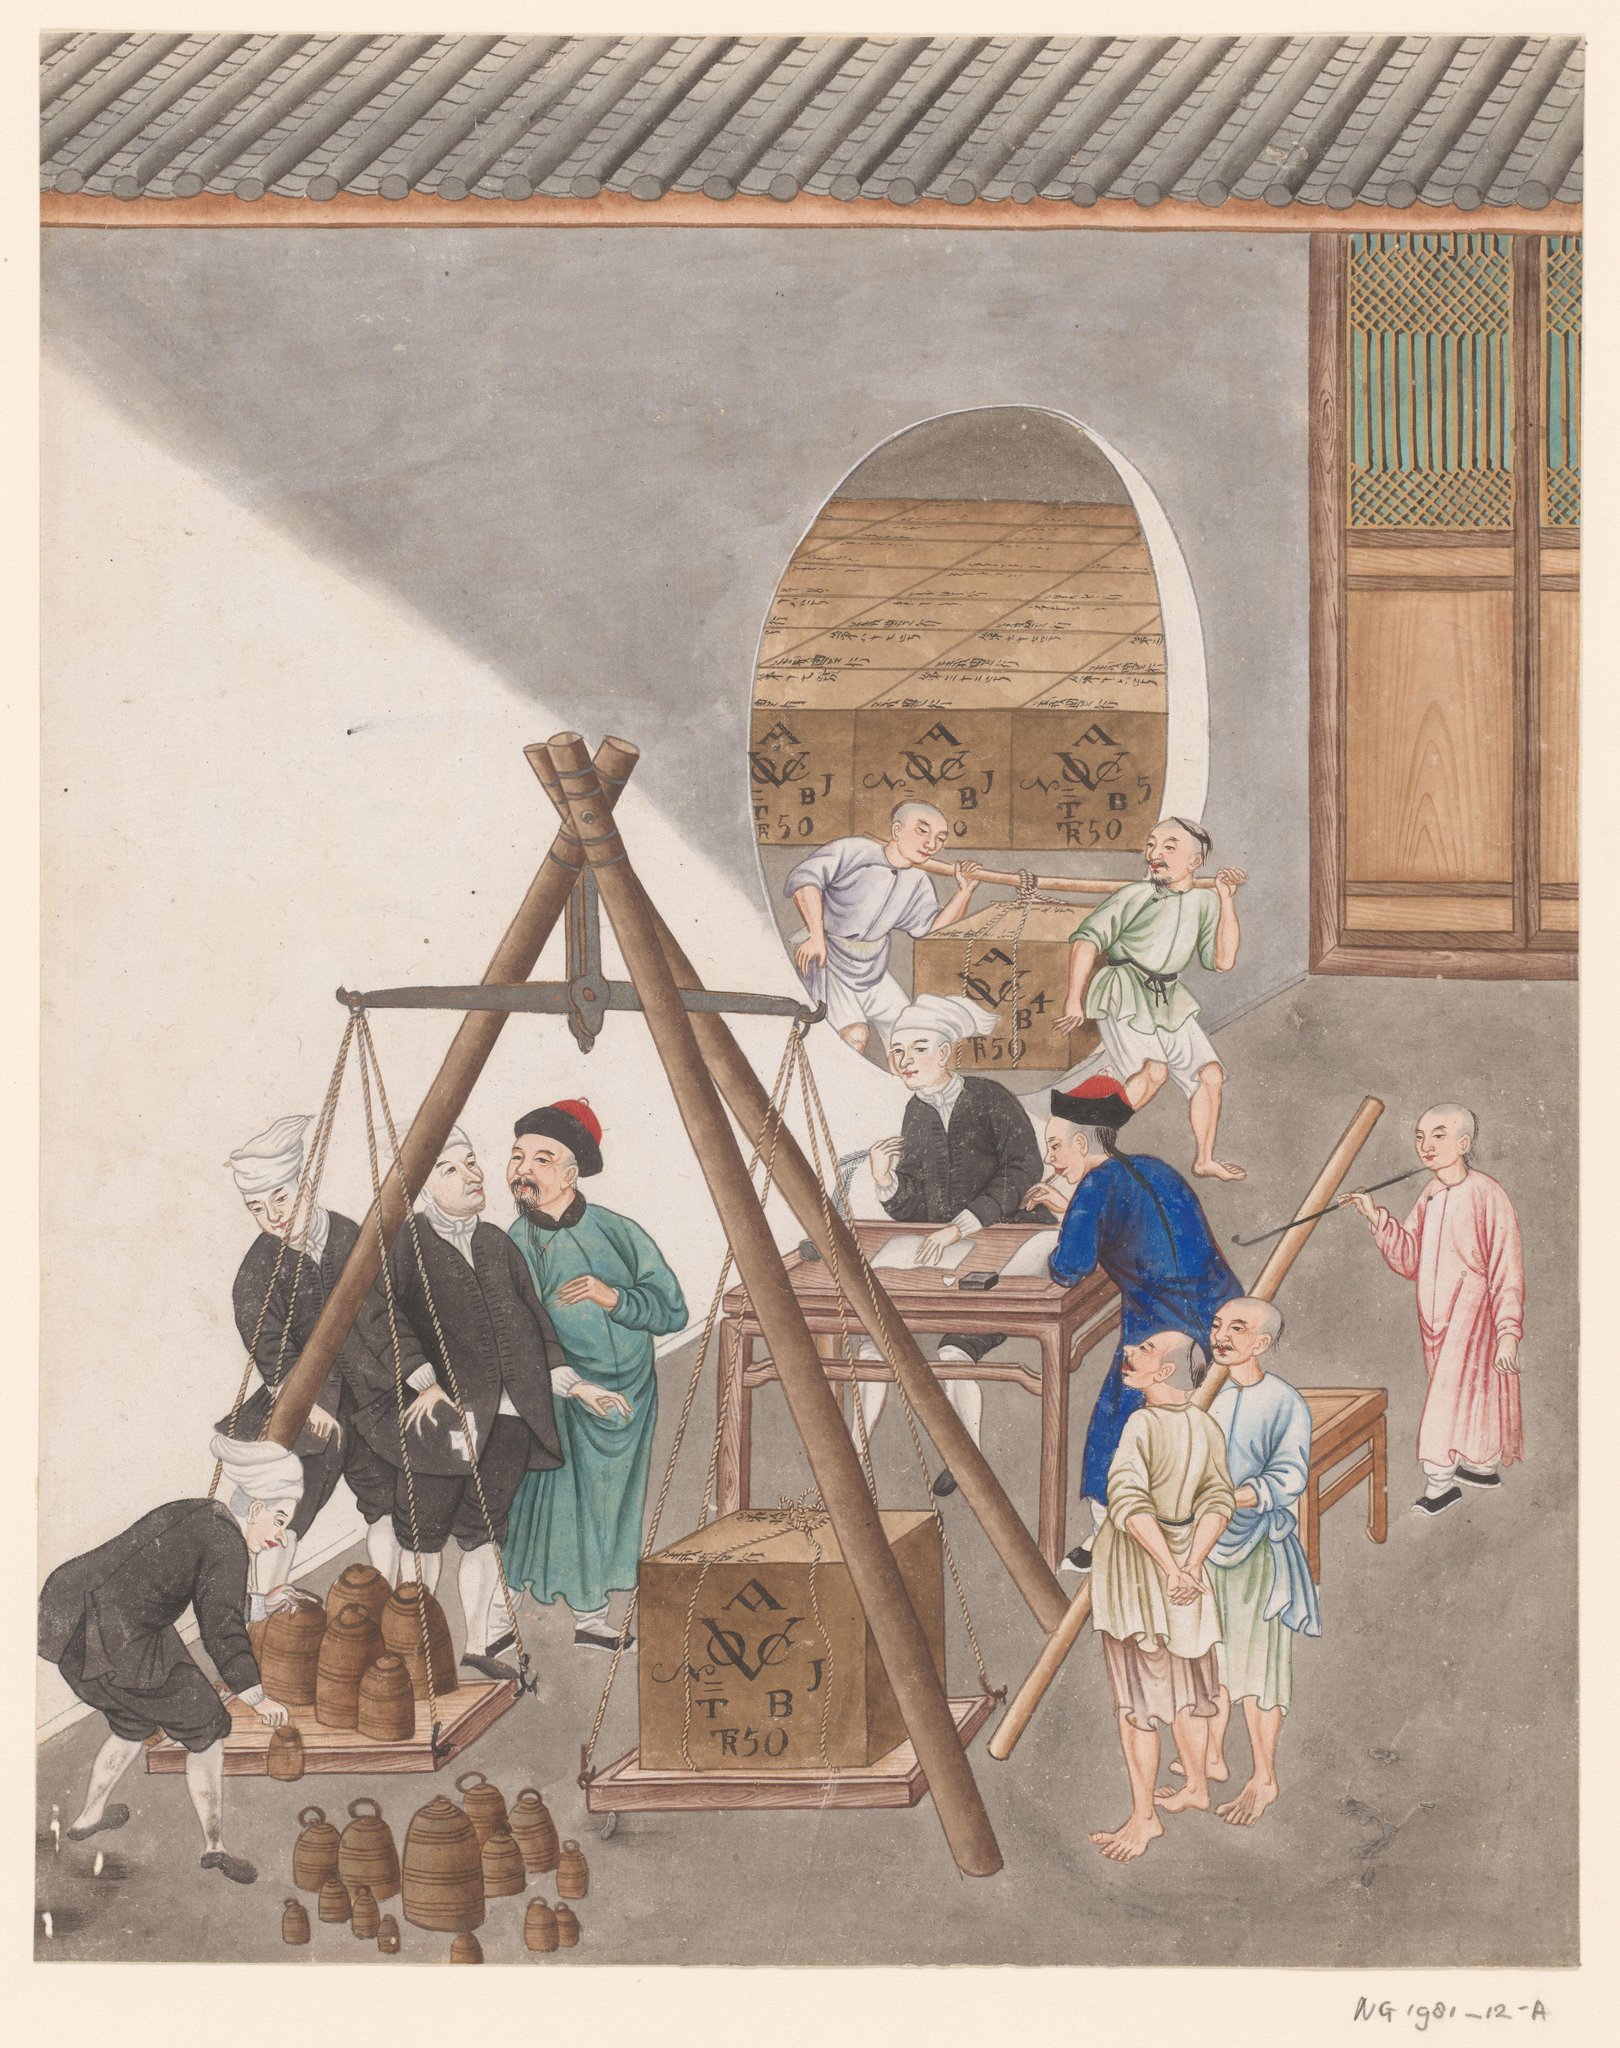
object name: drawing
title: Determining the weight of the tea chests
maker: Anonymous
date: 1770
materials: paint, gouache, paper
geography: china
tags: large-scale structure for storage, e.g.: warehouse, depot, silo, scales, tea (leaves), china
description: Het wegen van een kist met thee waarop het VOC insigne in een Chinees handelshuis in Kanton. Doorkijk in een ruimte vol met kisten met het VOC insigne en de naam van het Chinese handelshuis Yfeng Hang. Links een groep van drie Hollandse handelaren, achter een tafel noteren een Hollandse en een Chinese klerk de getallen. De voorstelling bovenaan afgesloten door de rand van een dak. Onderdeel van een groep van vier gouaches over de productie en export van Chinese thee door de VOC rond 1750.